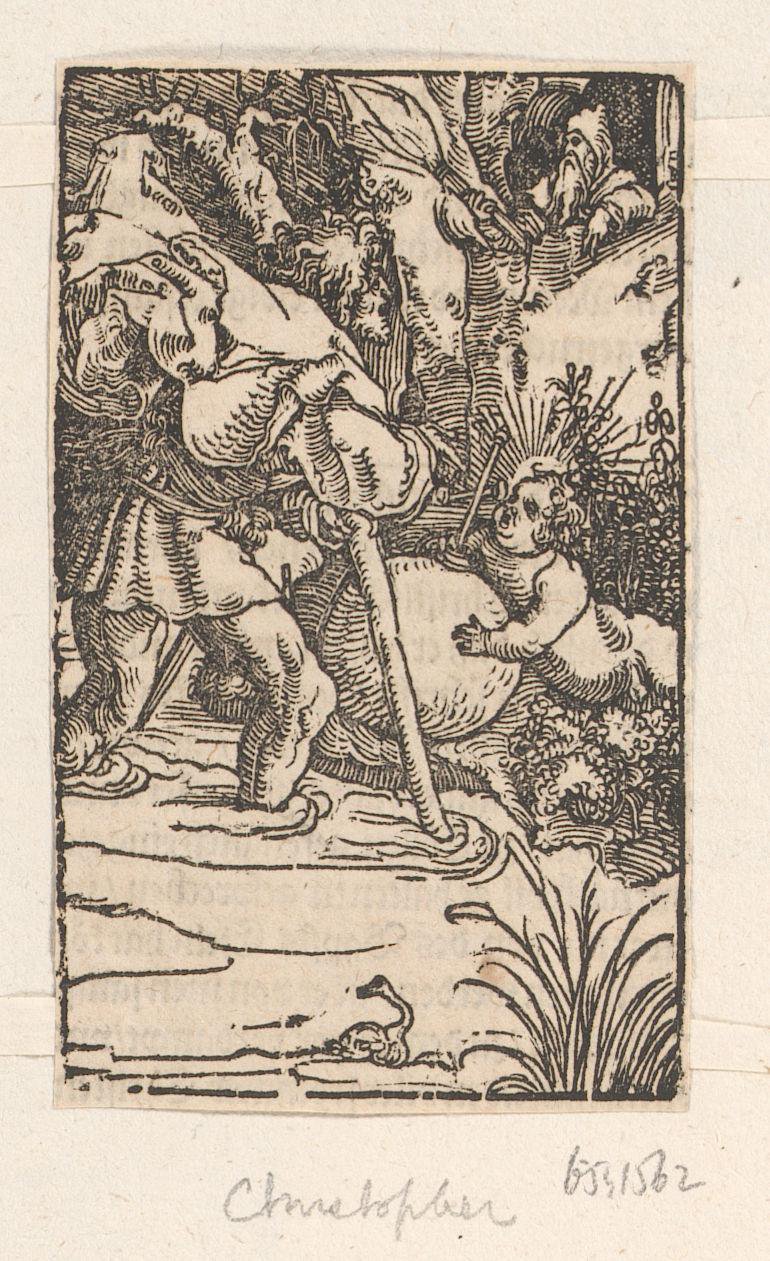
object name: print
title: H. Christoffel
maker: Anonymous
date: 1500-1536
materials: paper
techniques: letterpress printing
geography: germany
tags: the christ-child calls st. christopher to carry him across the river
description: De heilige Christoffel waadt door een rivier met een stok in zijn rechterhand. Hij ontmoet het Christuskind, die een wereldbol in zijn handen houdt, en hem vraagt om hem over de rivier te zetten. Op de oever staat een kluizenaar met een fakkel. Prent maakt deel uit van een album.